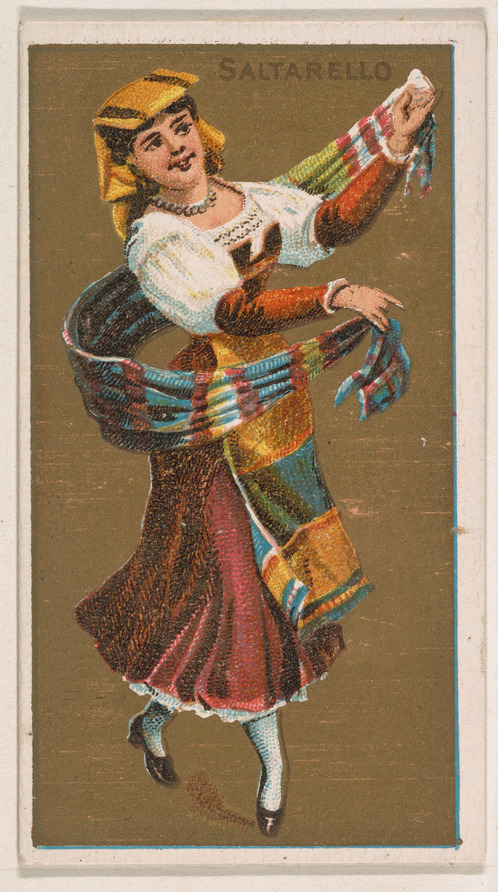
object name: print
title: Saltarello, from National Dances (N225, Type 1) issued by Kinney Bros.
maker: kinney brothers tobacco company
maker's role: publisher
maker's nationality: american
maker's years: 1869-2011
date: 1889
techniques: color lithograph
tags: dance,women,dancers